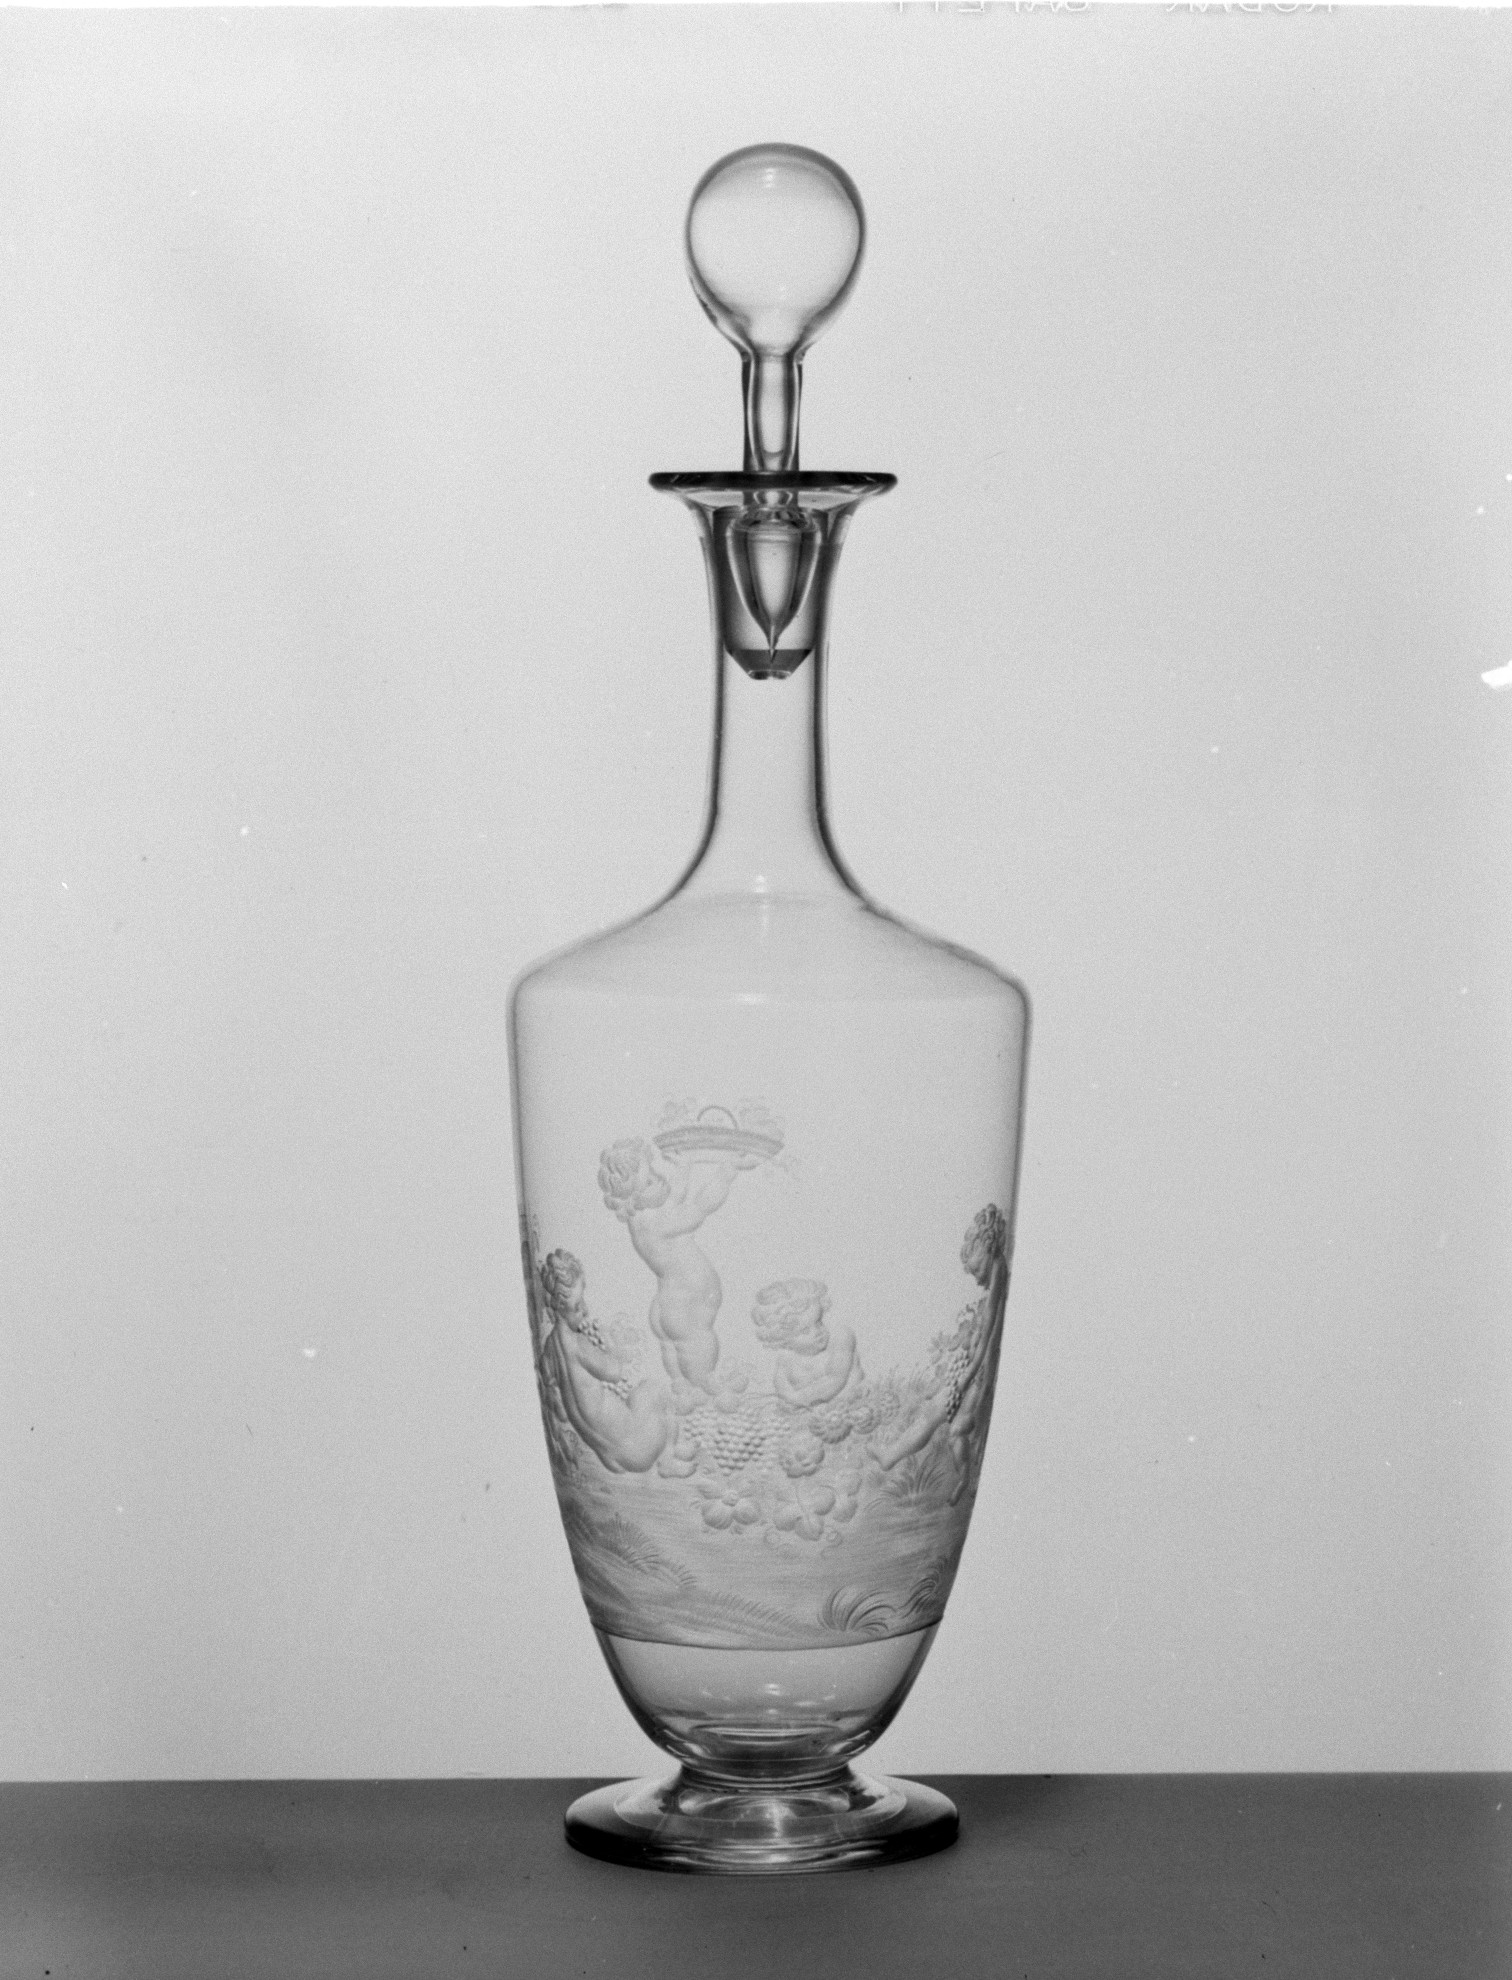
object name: decanter with stopper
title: Decanter with scene of children harvesting grapes (Autumn) (one of a pair)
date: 1870-1880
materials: glass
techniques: engraving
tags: grapes,putti